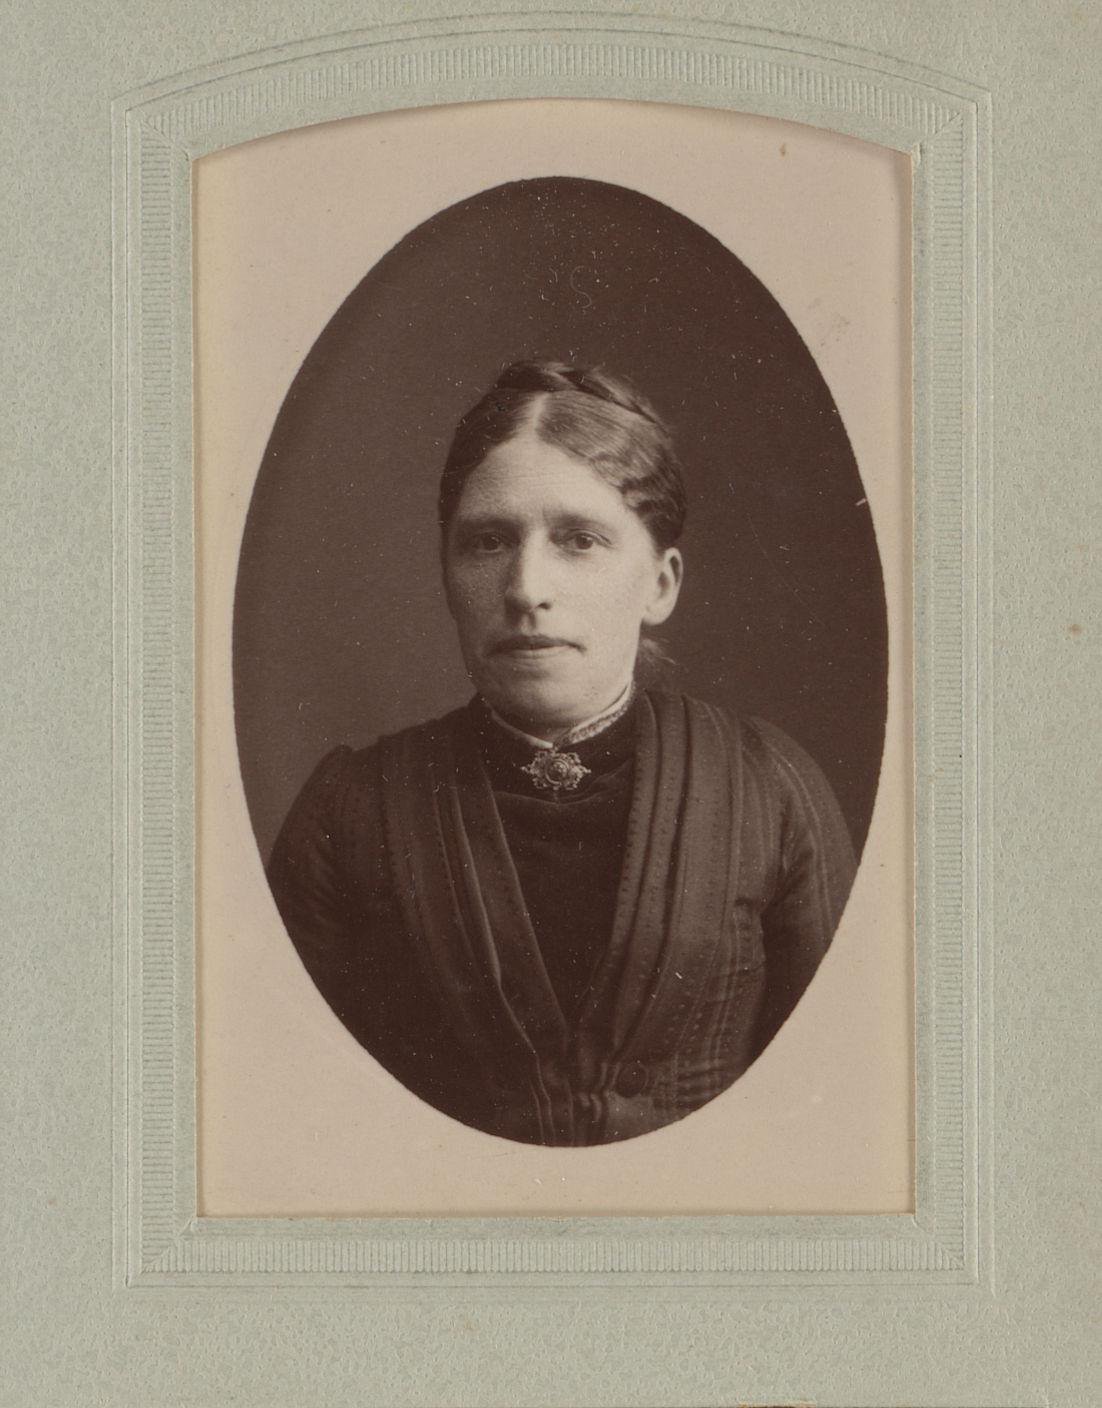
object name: album leaf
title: Portret van een vrouw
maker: willem gerhardus kuijer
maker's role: fotograaf, hoffotograaf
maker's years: 1834-1899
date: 1890-1910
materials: cardboard, celluloid, photographic support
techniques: albumen print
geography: amsterdam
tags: adult woman, historical persons